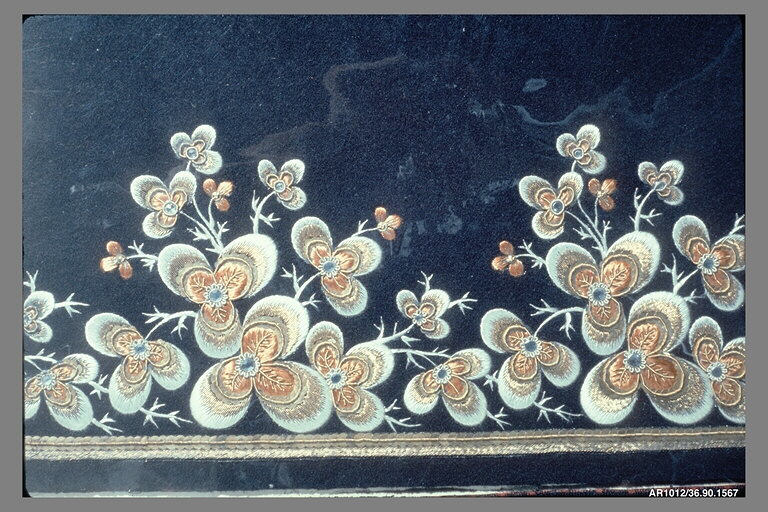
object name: sample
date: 1801-1833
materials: felt, metal thread, silk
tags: flowers